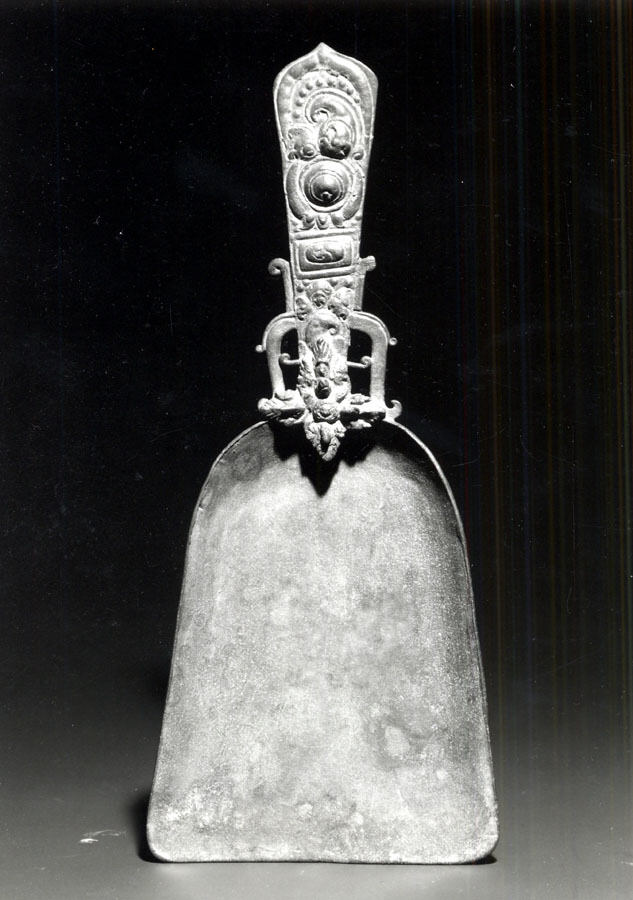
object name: rice shovel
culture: indonesian, javanese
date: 867-1000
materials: bronze